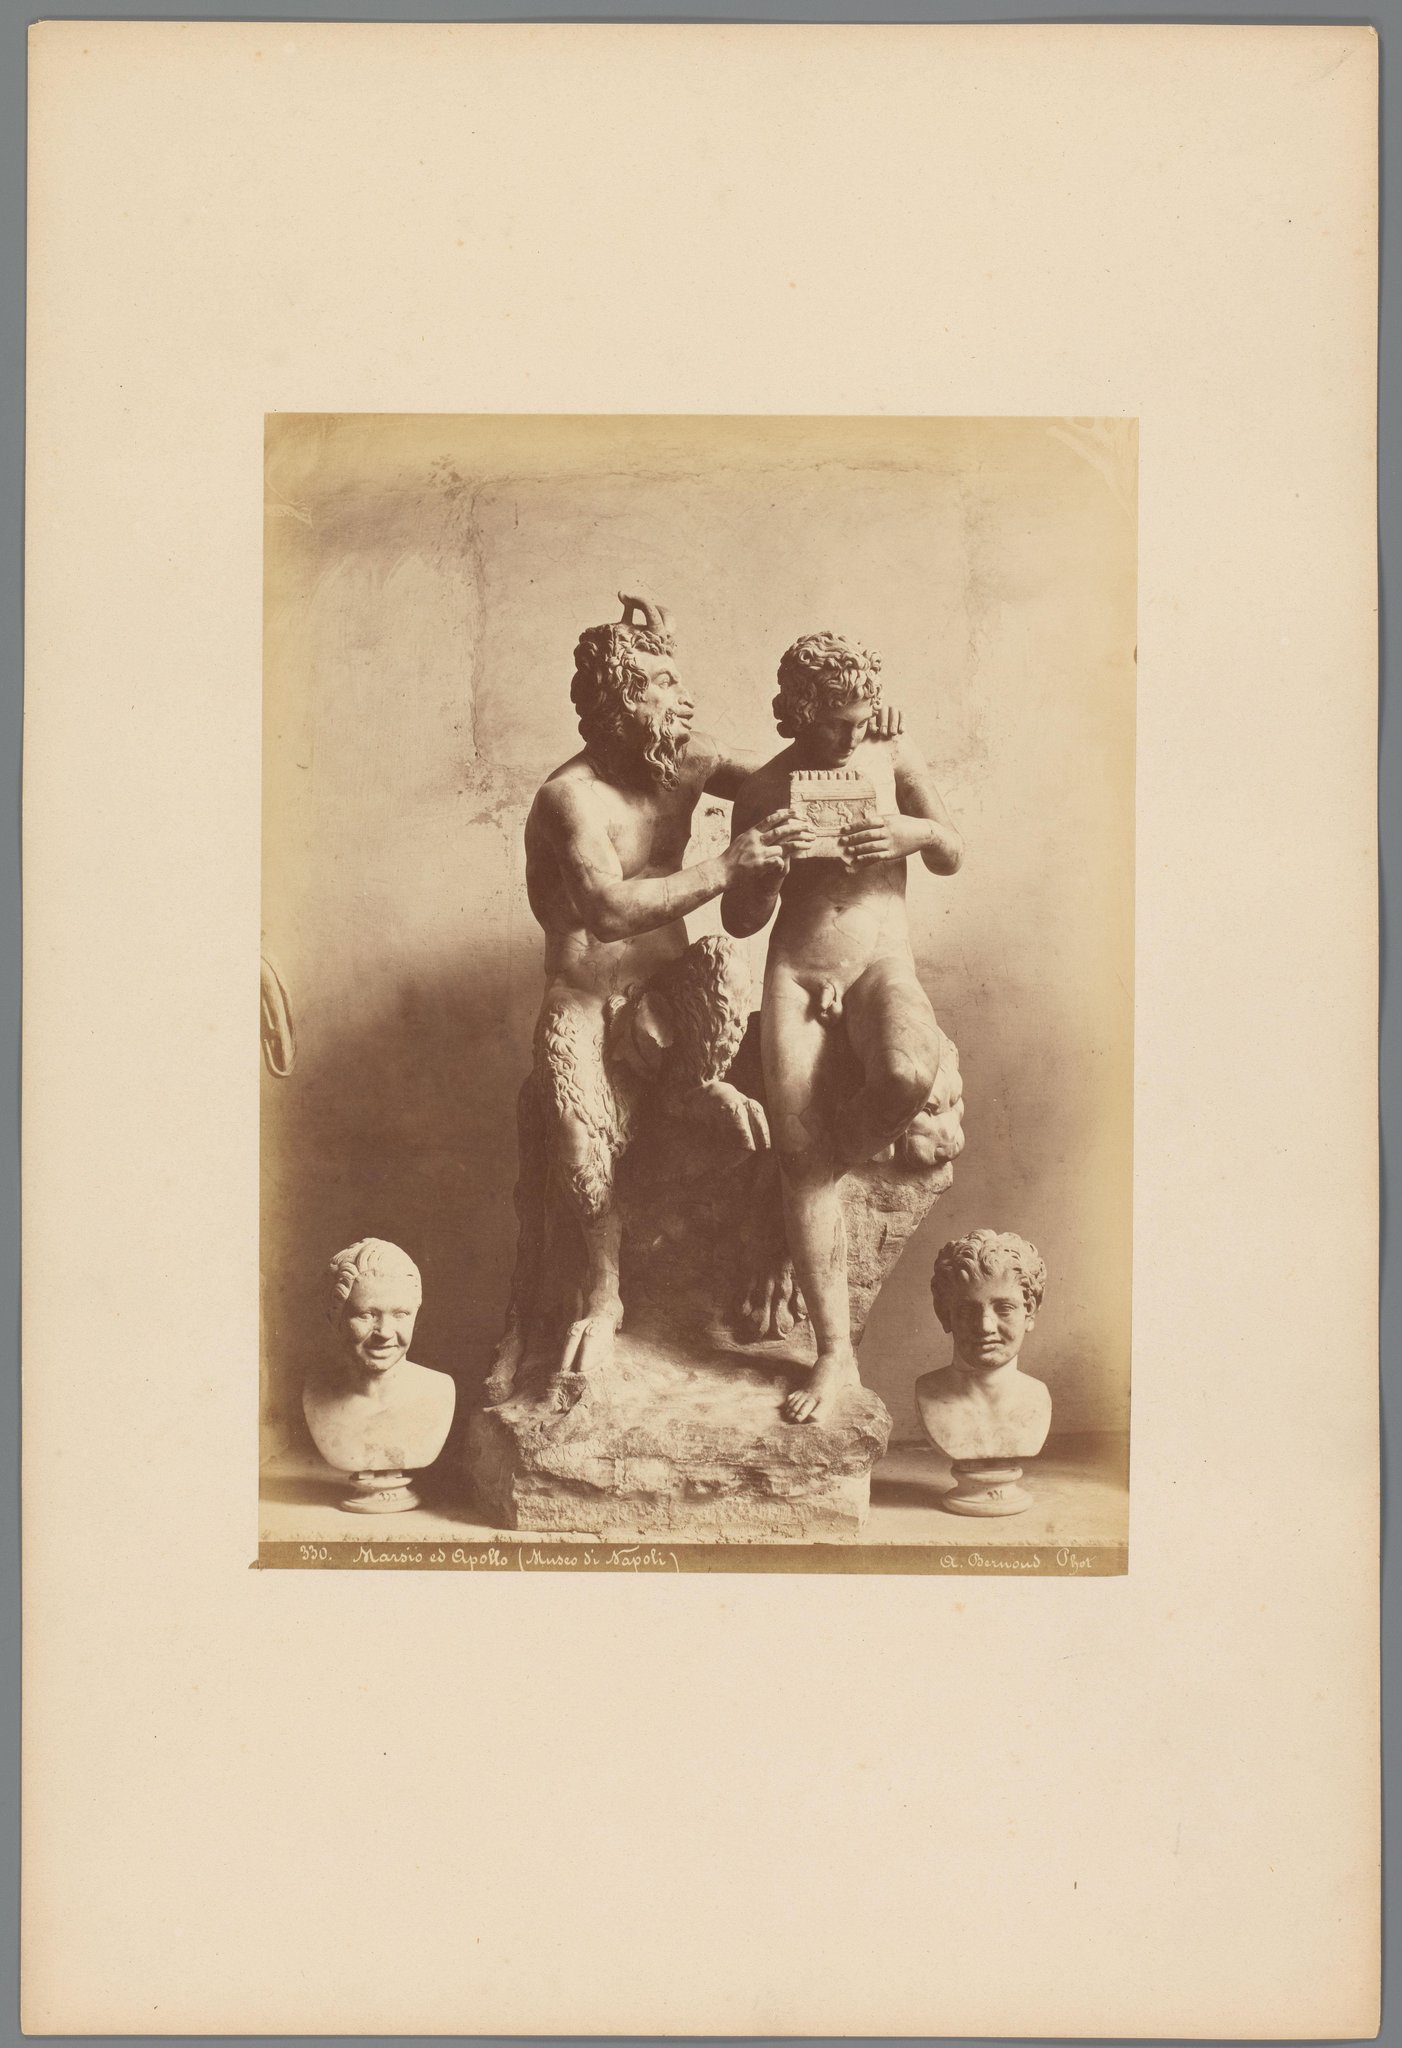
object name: photograph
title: Sculptuur van Pan en Apollo, of Marsyas en Olympos in de Napolitaanse Musea, Italië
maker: alphonse bernoud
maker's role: fotograaf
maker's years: 1820-1889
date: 1851-1873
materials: cardboard, paper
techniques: albumen print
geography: naples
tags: he-goat, billy-goat, (story of) marsyas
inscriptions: number: ‘330.’